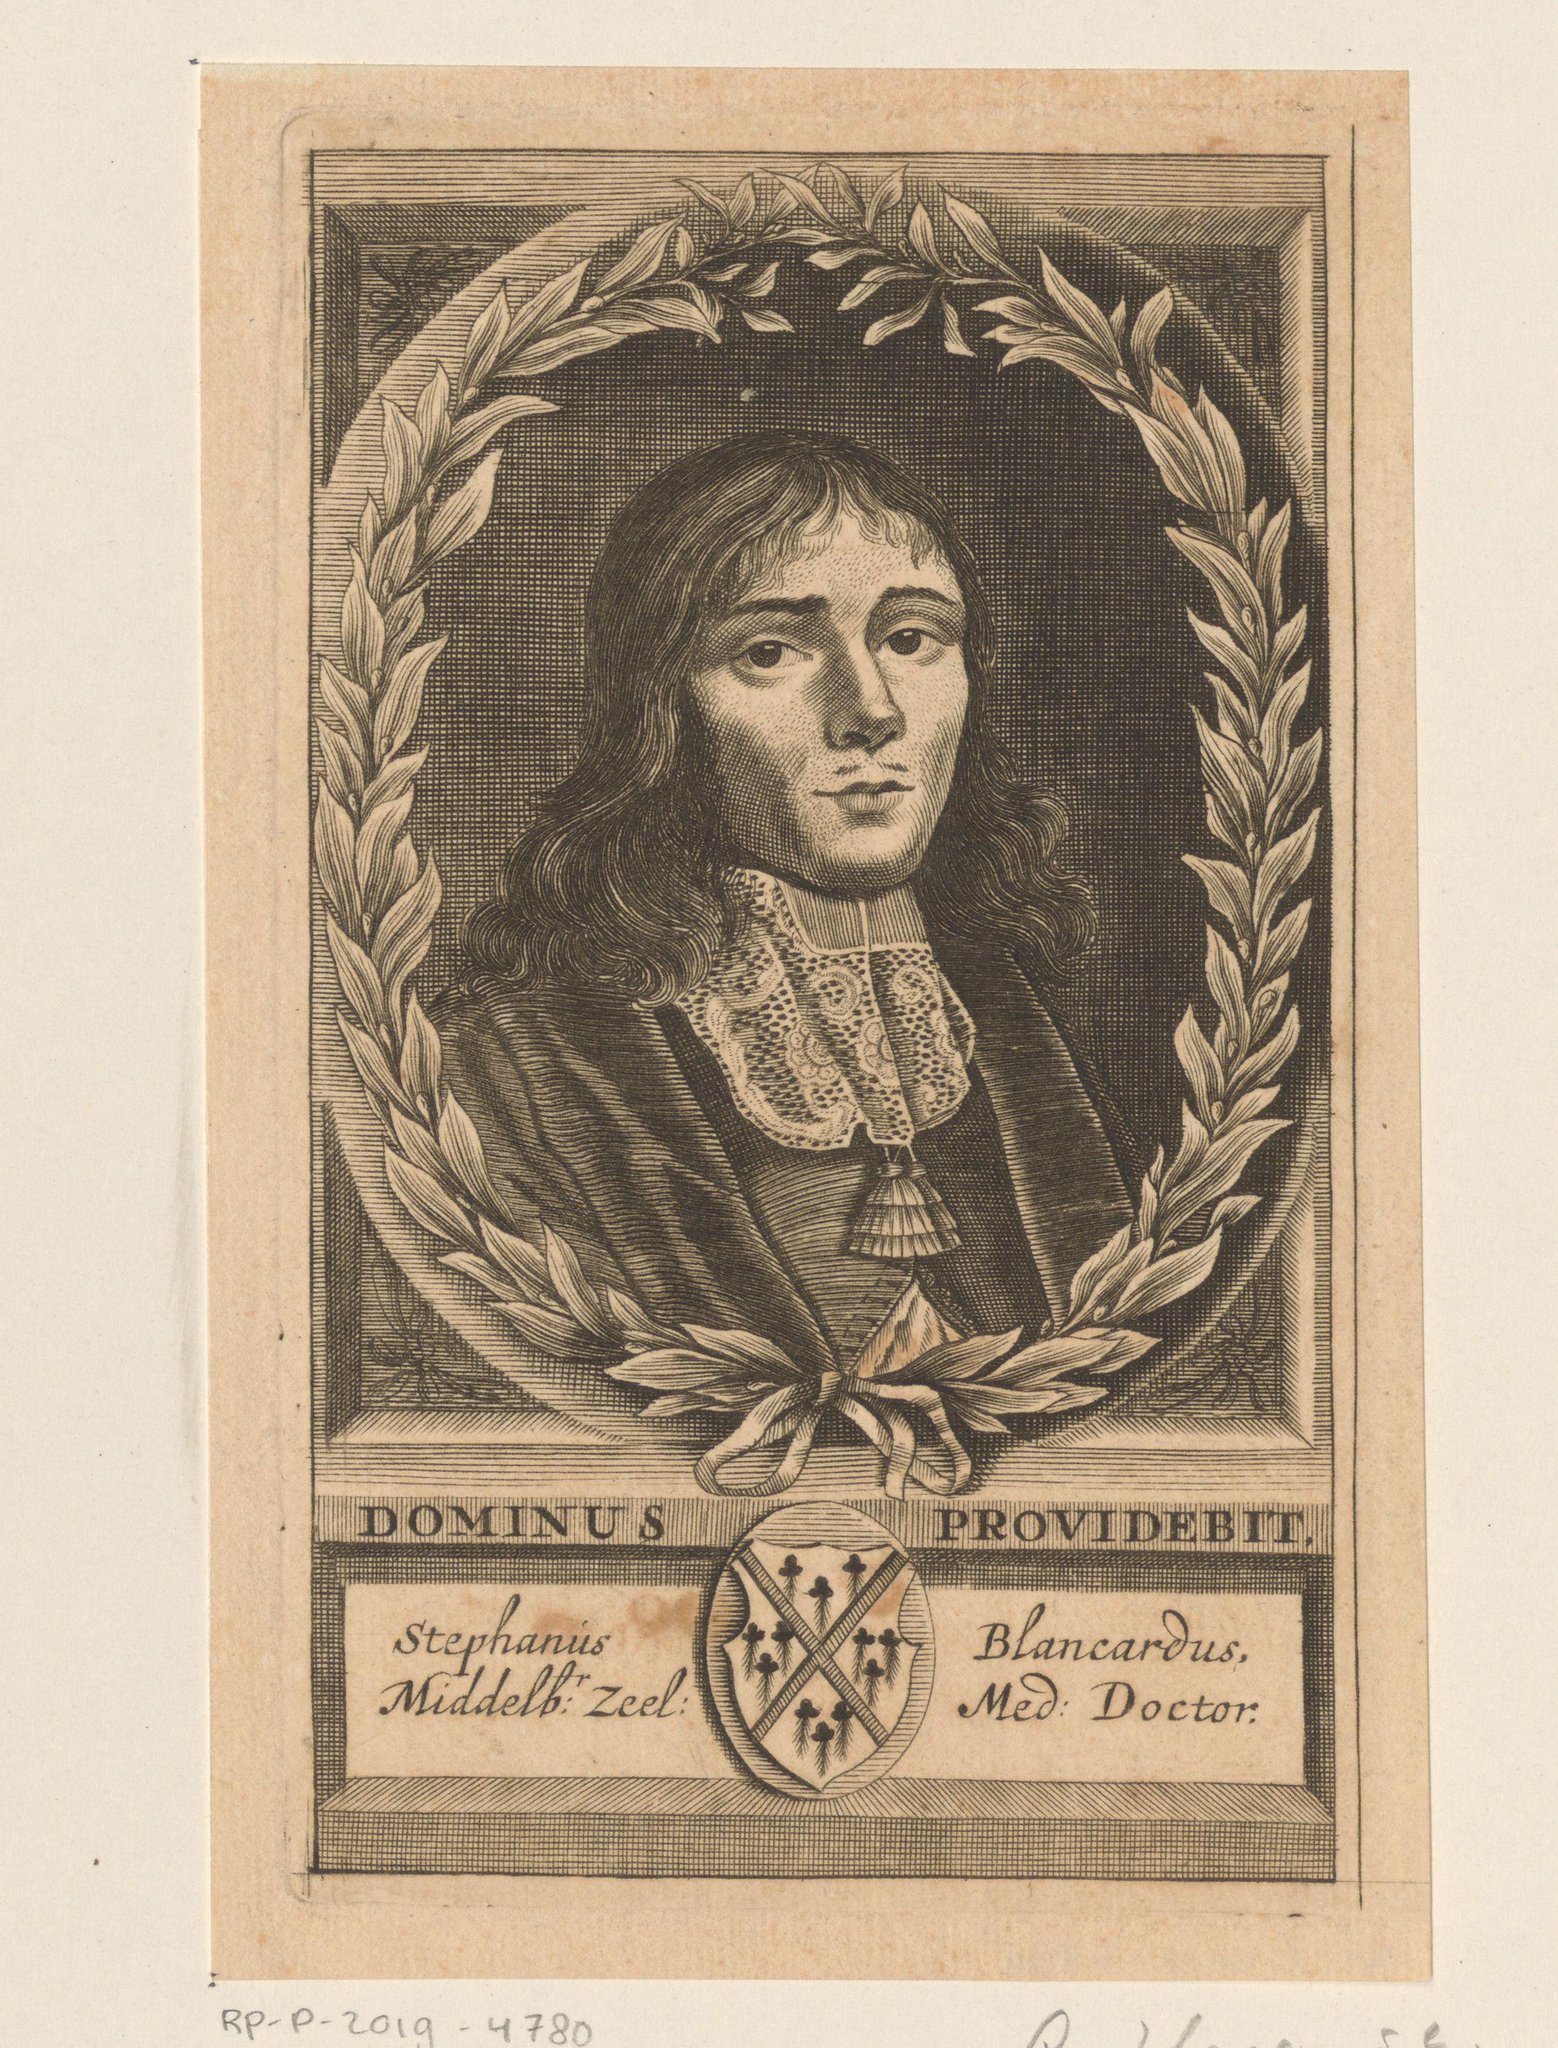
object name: book illustration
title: Portret van Steven Blanckaert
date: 1678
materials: paper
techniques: engraving, etching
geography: amsterdam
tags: amsterdam, historical persons, armorial bearing, heraldry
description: Prent uit: Blanckaert, Steven. De nieuw hervormde anatomia, ofte ontleding des menschen lighaams. Amsterdam: Jan Claesz ten Hoorn, 1678.